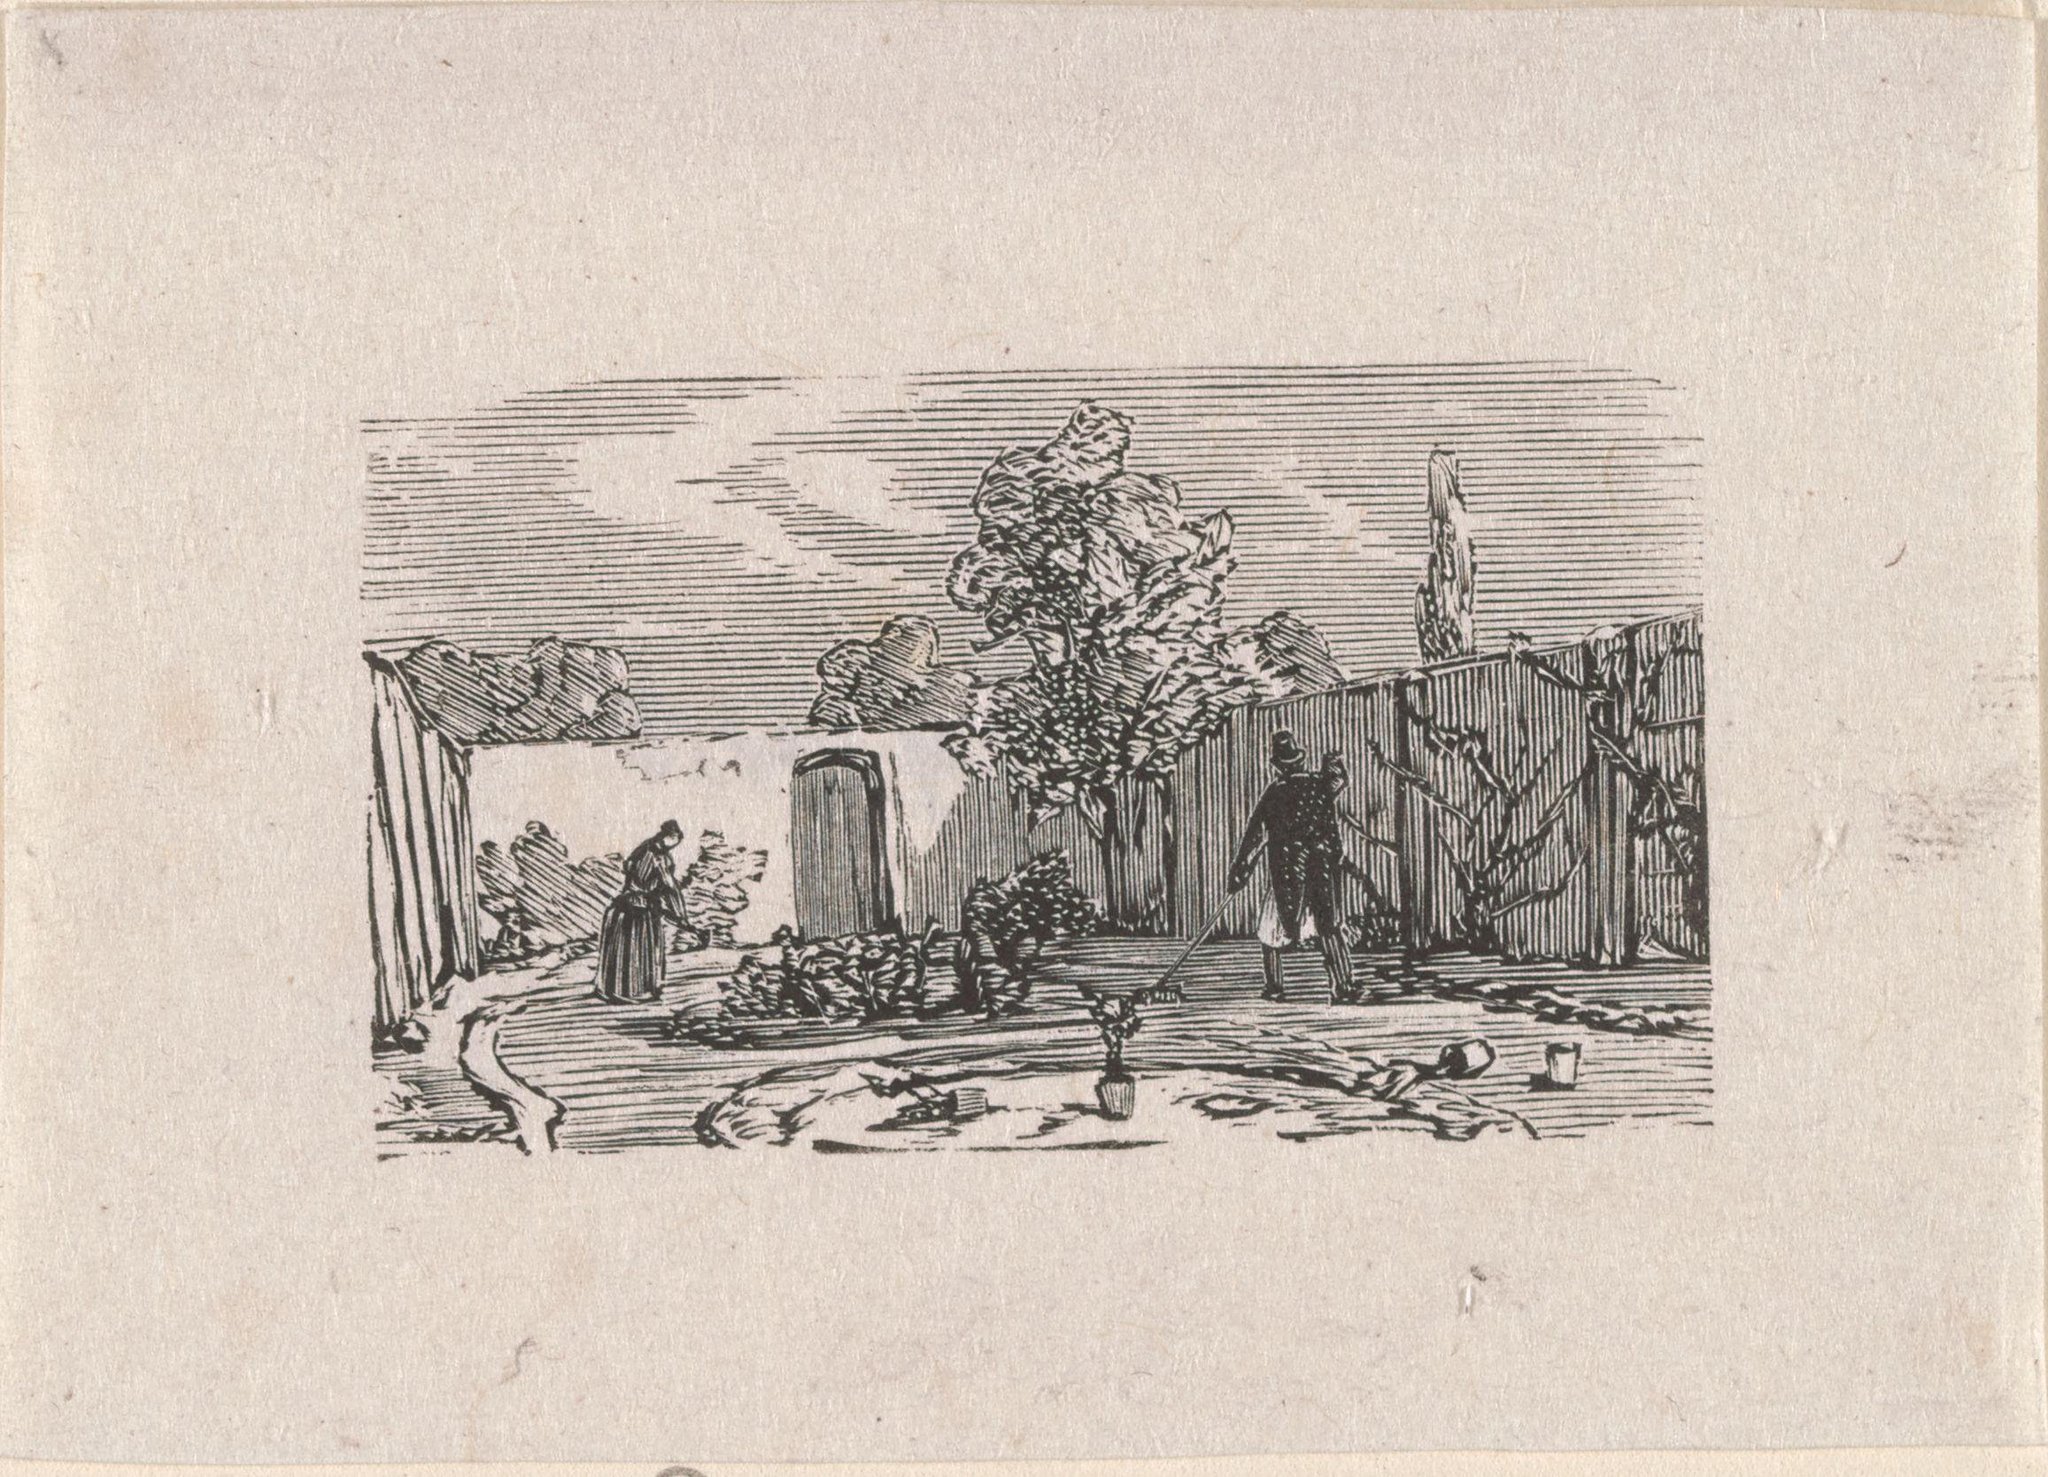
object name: print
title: Maanden van het jaar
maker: isaac weissenbruch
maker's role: print maker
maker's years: 1826-1912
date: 1836-1912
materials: paper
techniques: engraving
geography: netherlands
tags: standing figure, the twelve months represented by scenes showing human activities, usually in a landscape; so-called 'labours of the months', garden, standing figure - aa - female human figure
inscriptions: collector's mark: Lugt 2228